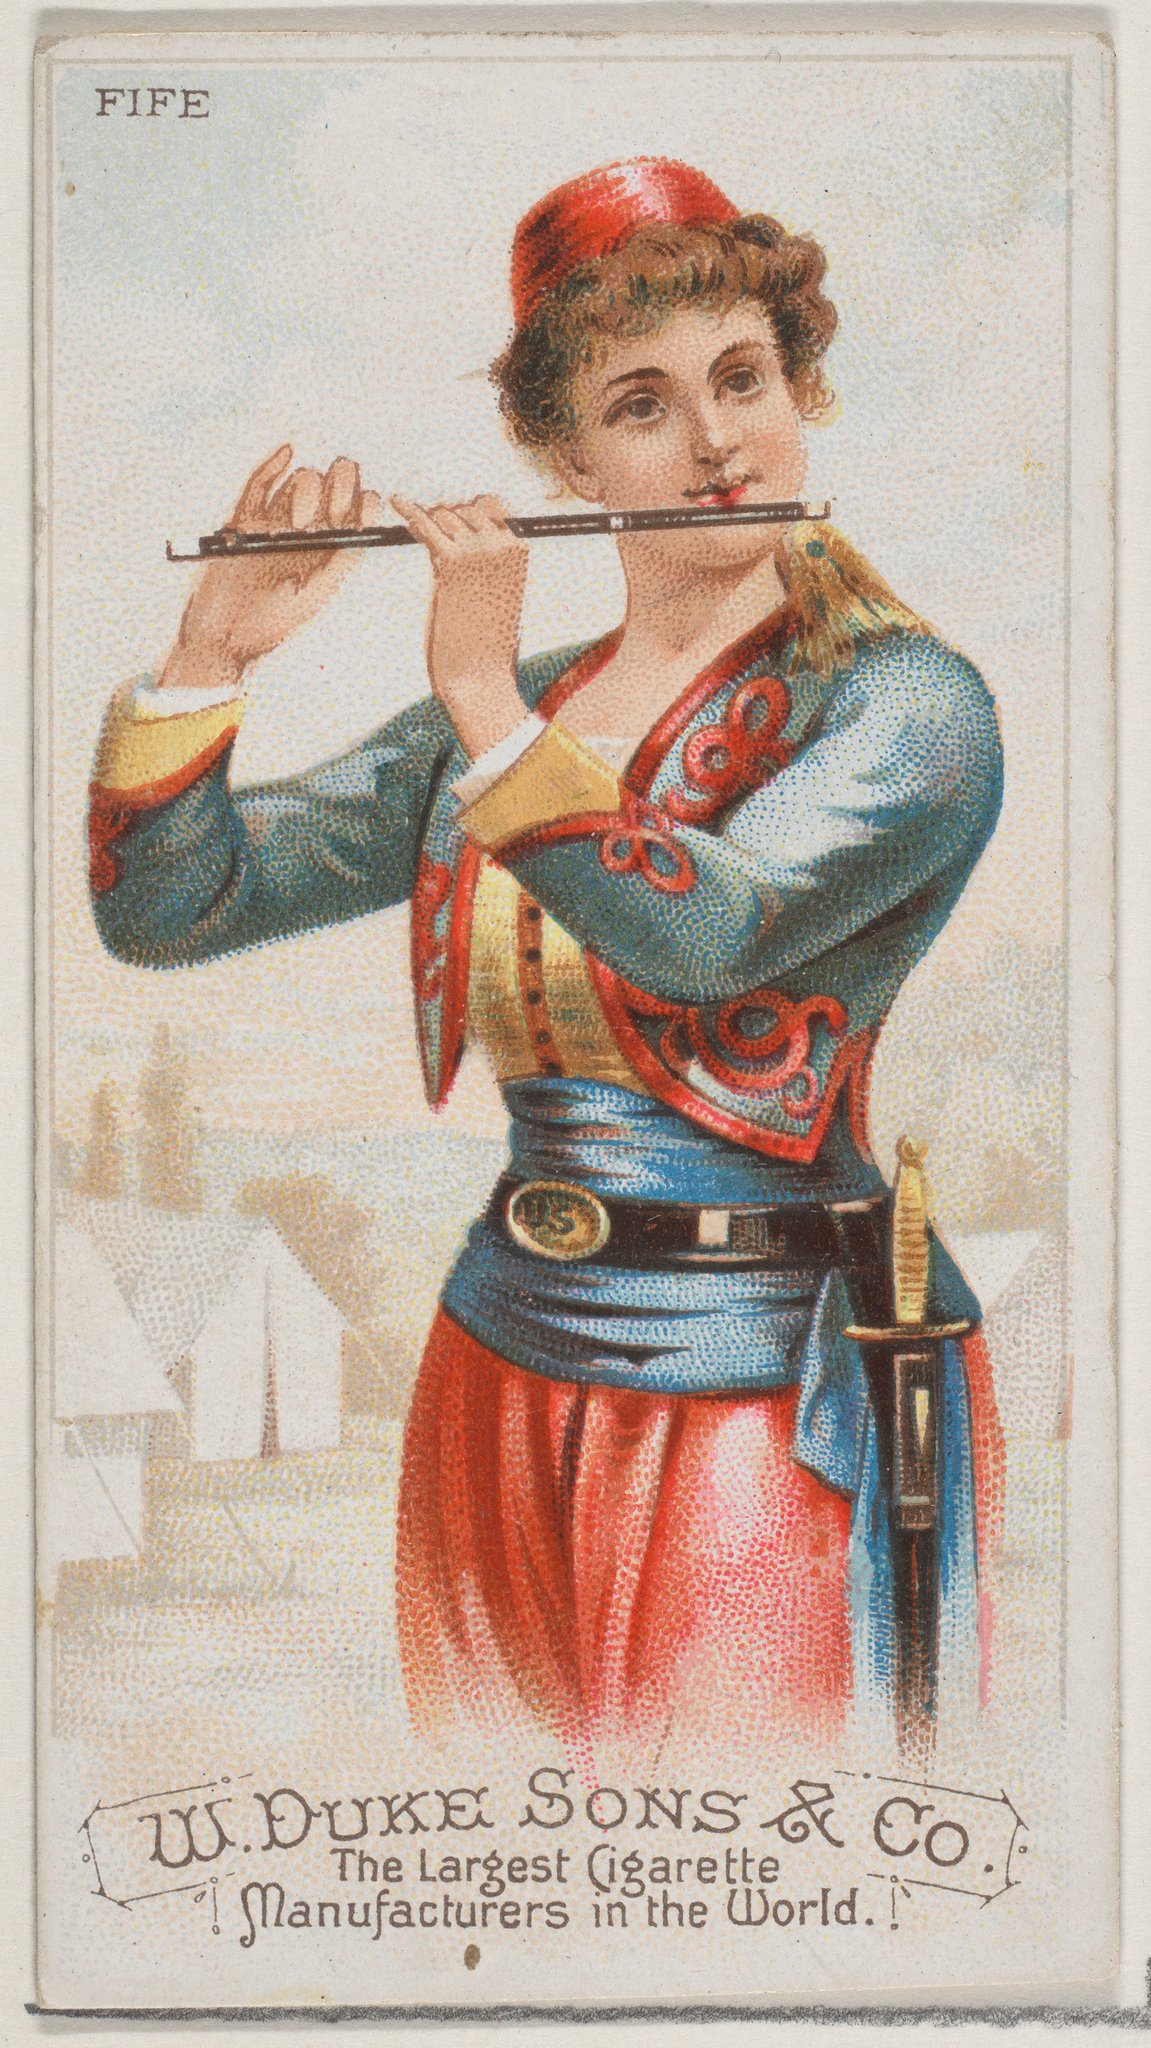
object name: print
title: Fife, from the Musical Instruments series (N82) for Duke brand cigarettes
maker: w. duke, sons & co.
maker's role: publisher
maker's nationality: american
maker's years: 1870-1920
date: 1888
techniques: color lithograph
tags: musical instruments,women,musicians